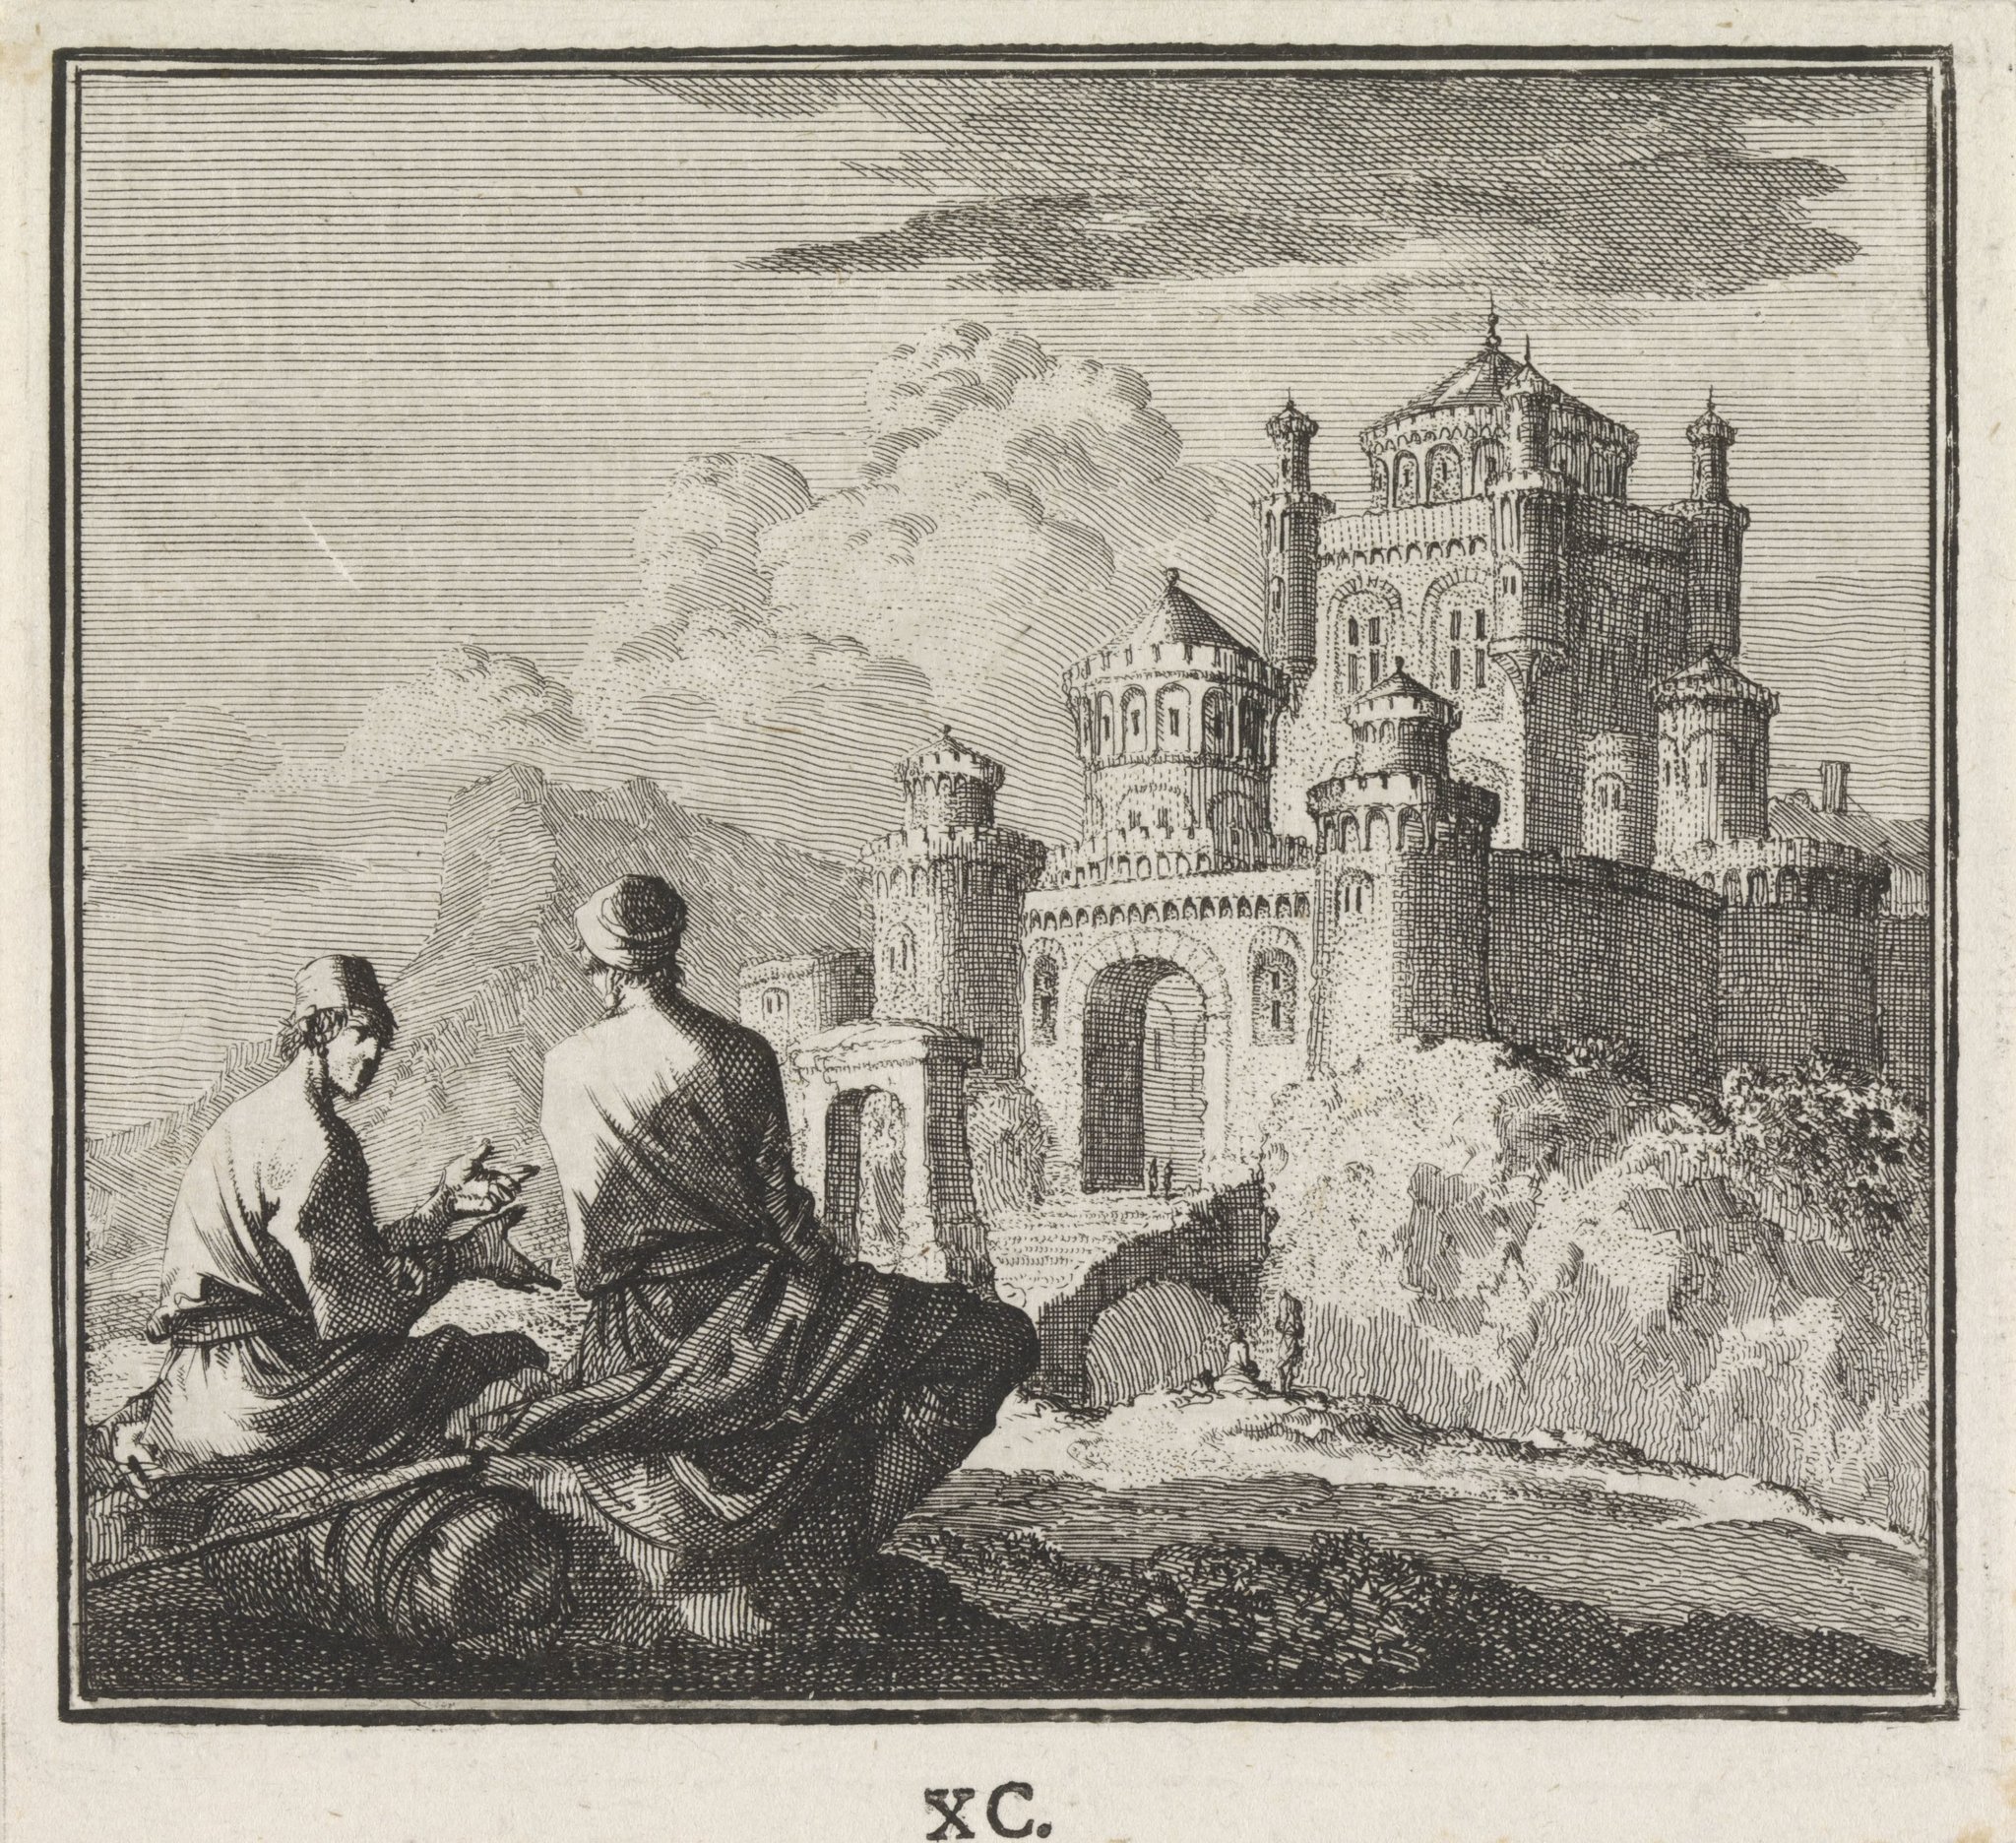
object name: print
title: Embleem: burcht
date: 1695-1705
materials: paper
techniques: etching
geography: amsterdam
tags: fortress, 'en route', traveller under way, abstract ideas and concepts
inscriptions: collector's mark: Lugt 2228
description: Boekillustratie voor Weigel, Christoph. Ethica Naturalis seu Documenta Moralia e Variis rerum Naturalium proprietatibus Virtutum Vitiorumq symbolicis imaginibus collecta. Neurenberg: Christoph Weigel: c. 1700.